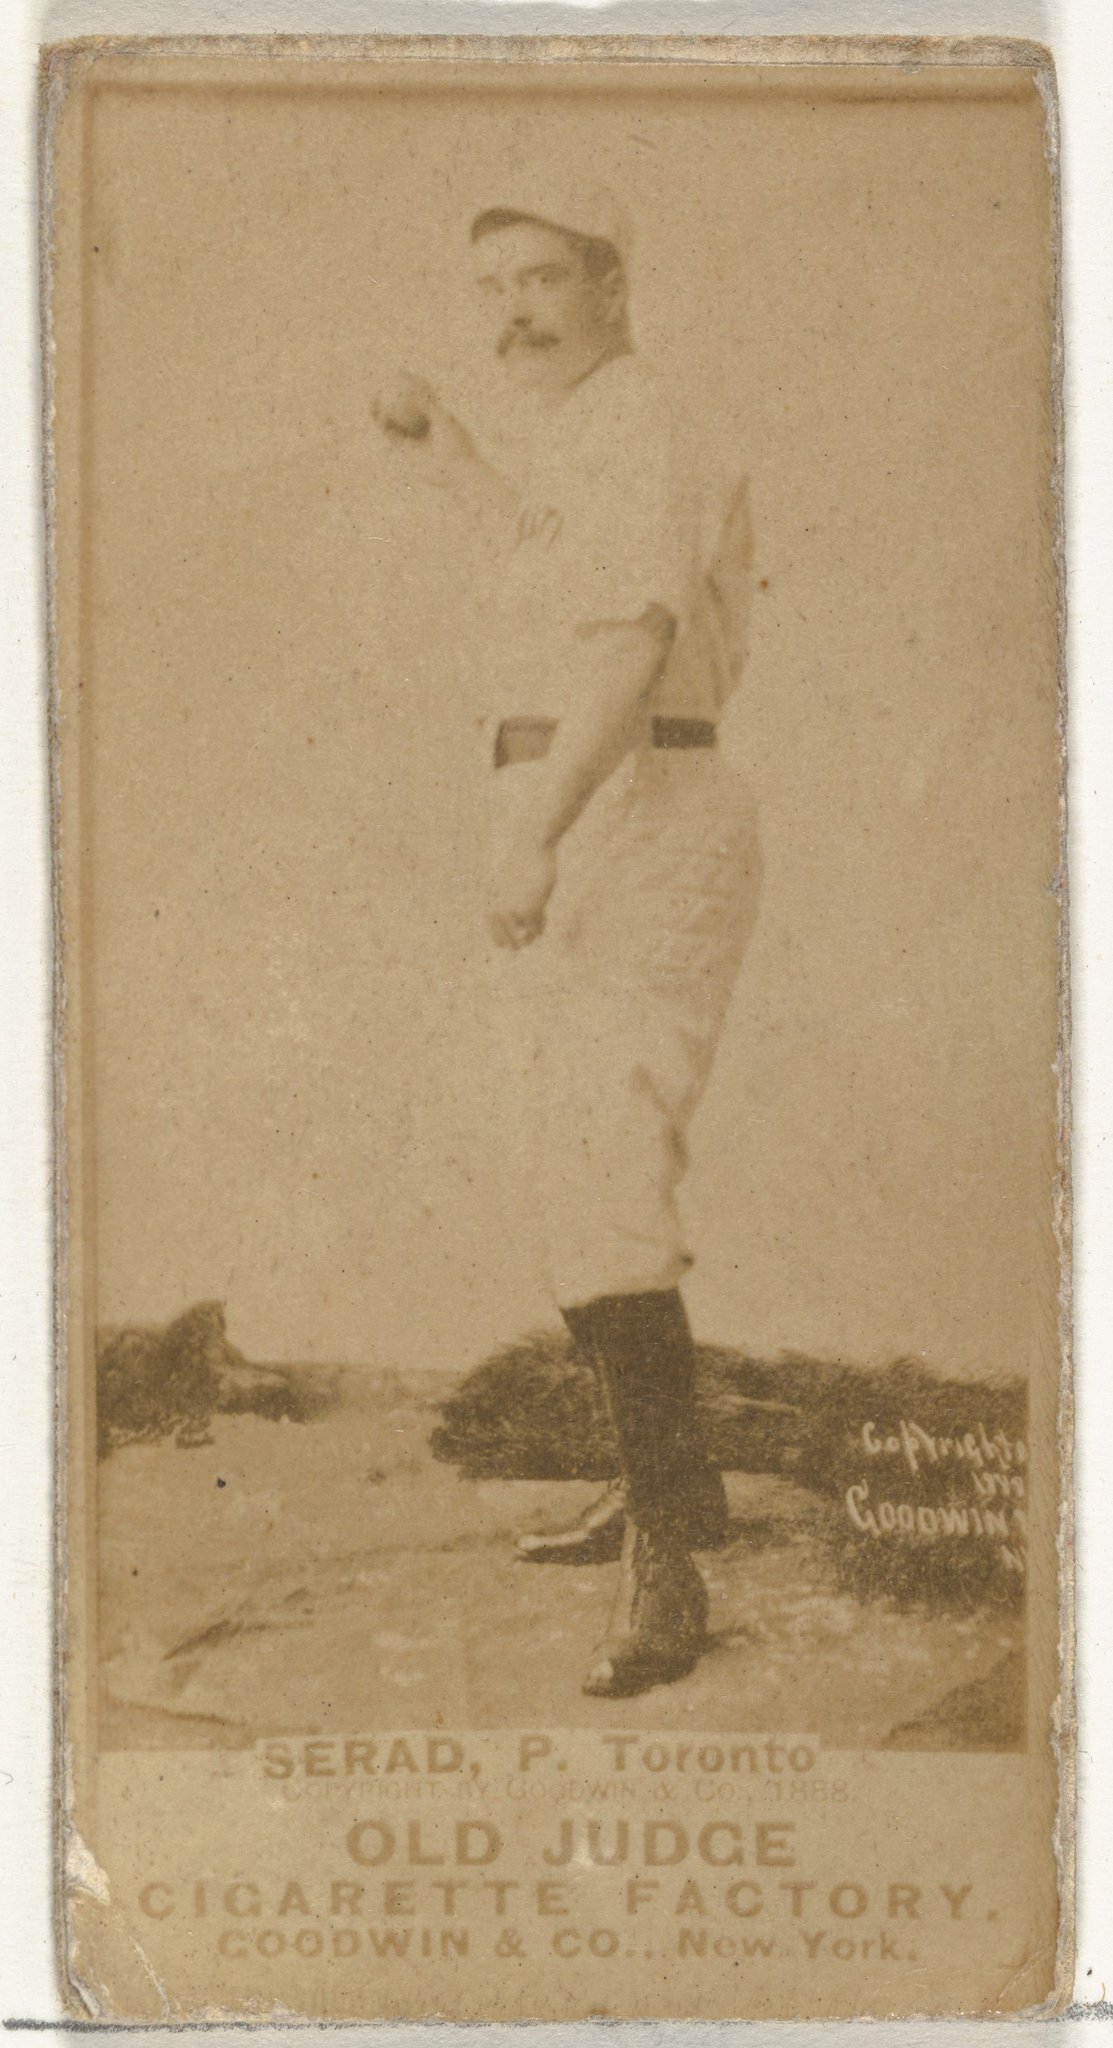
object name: baseball card, photograph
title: William I. "Billy" Serad, Pitcher, Toronto Canucks, from the Old Judge series (N172) for Old Judge Cigarettes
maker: goodwin & company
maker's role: publisher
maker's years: 1850-1950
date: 1888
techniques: albumen silver print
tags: men,portraits,baseball,athletes